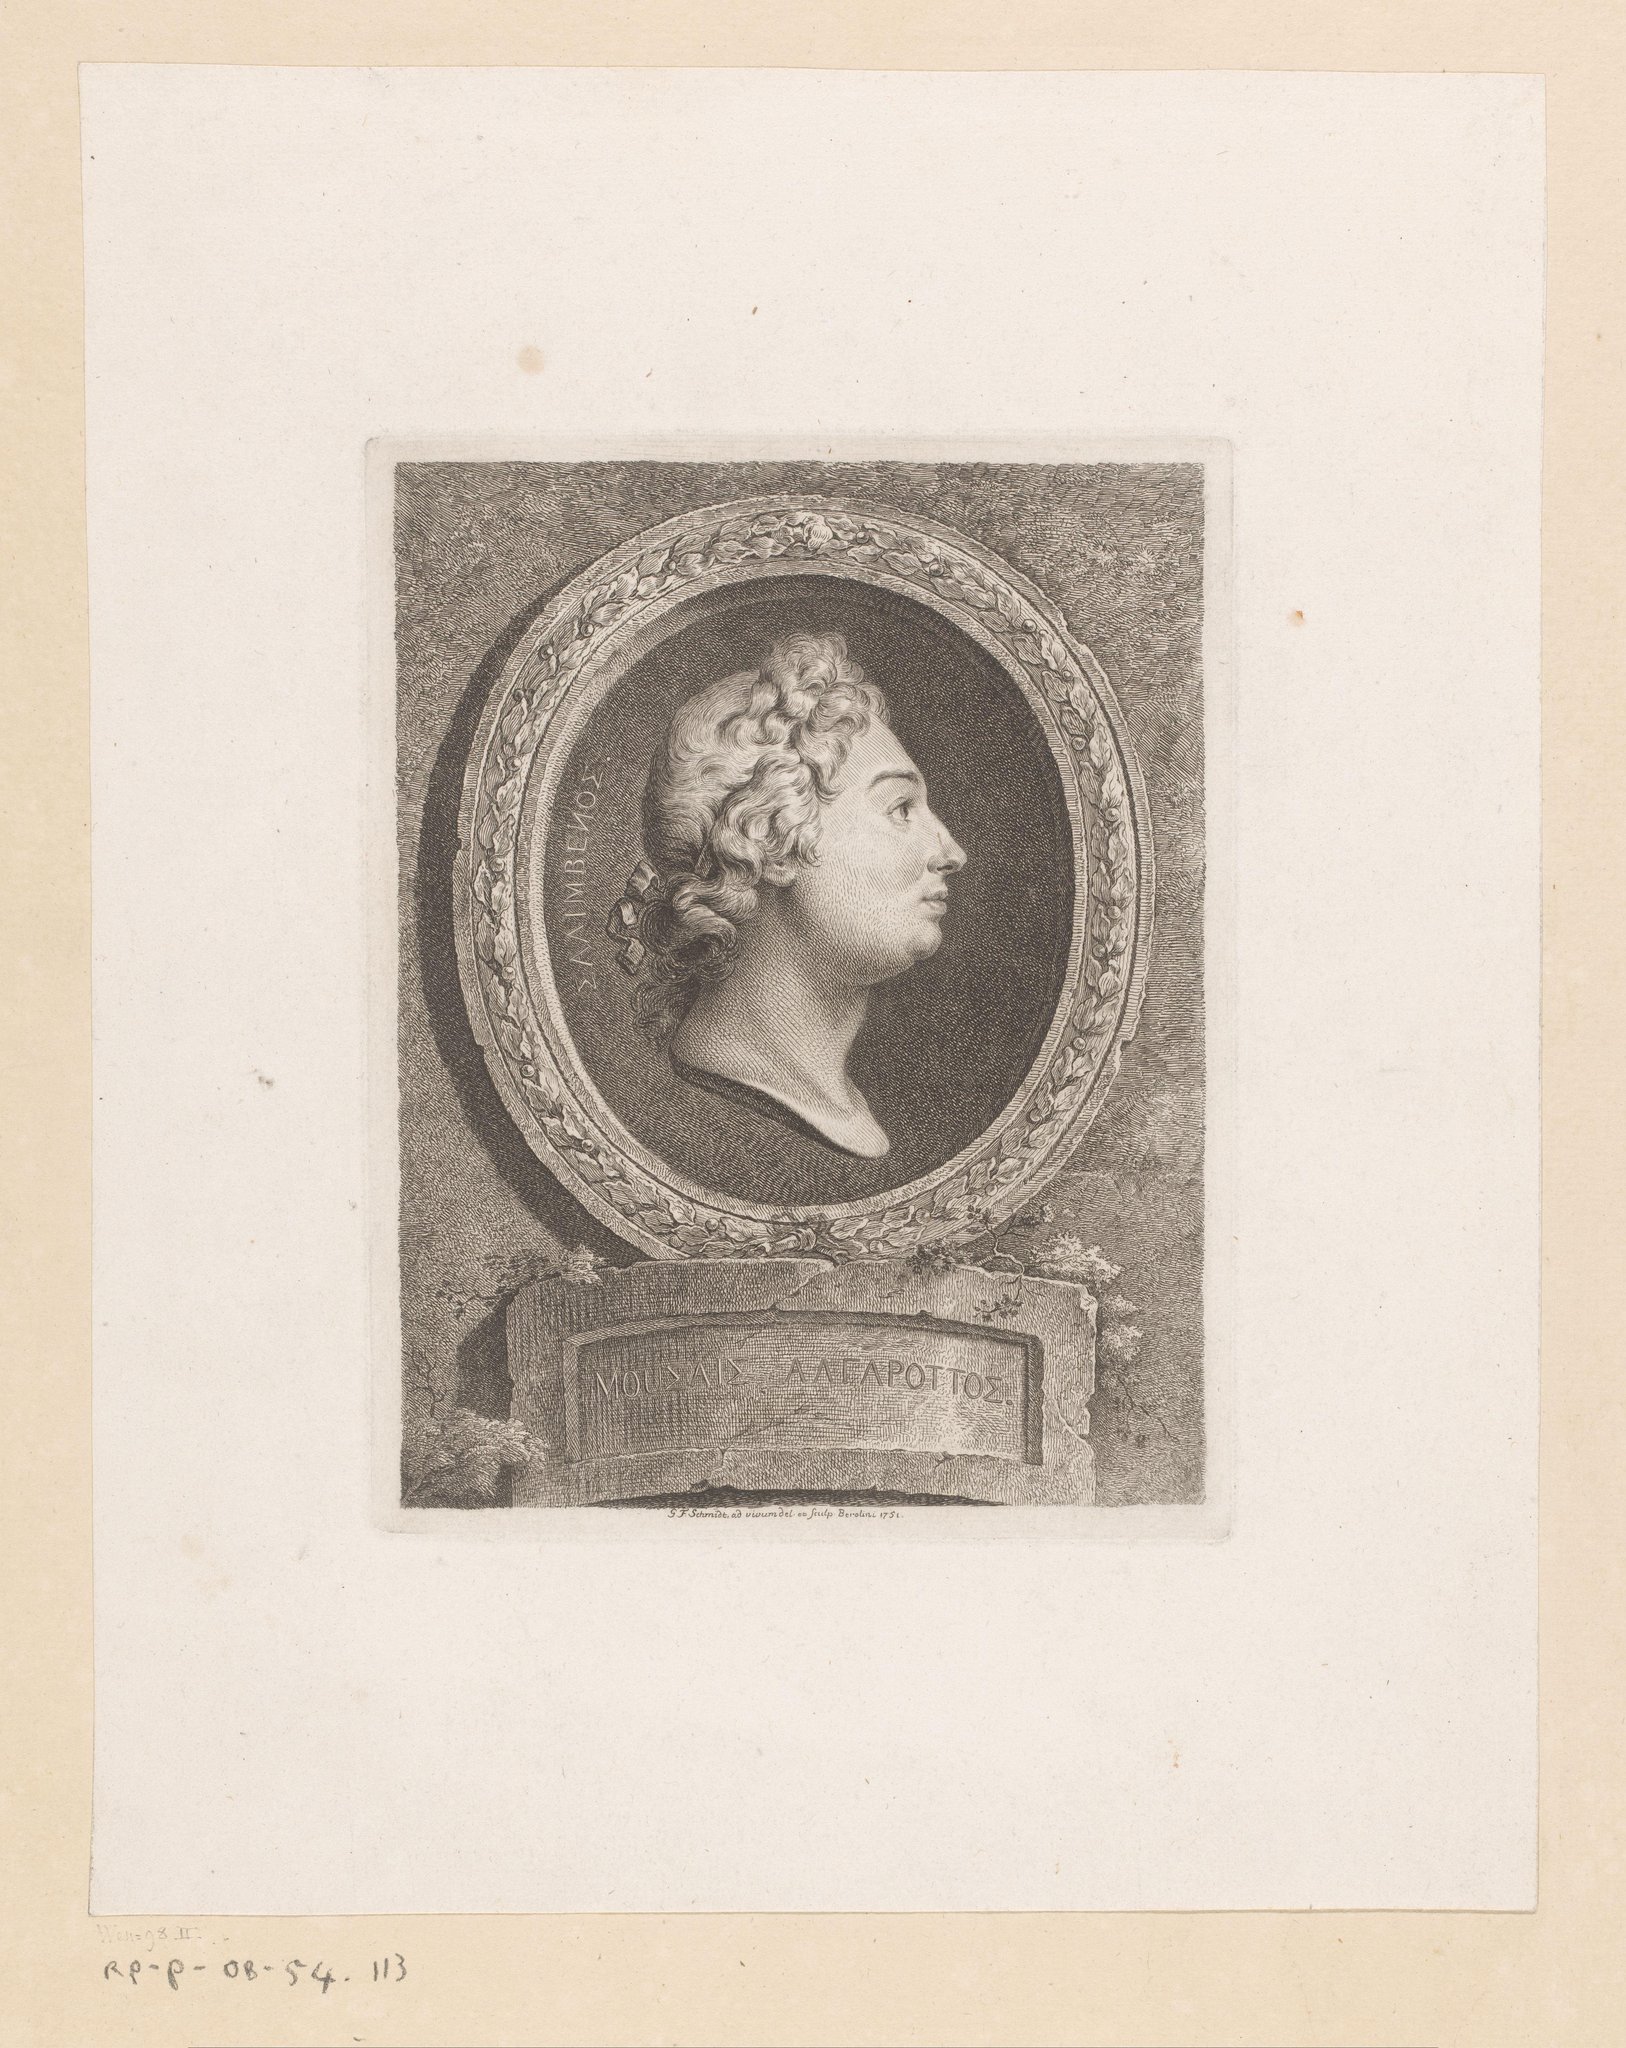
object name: print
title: Portret van Felice Salimbeni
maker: georg friedrich schmidt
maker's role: draughtsman, print maker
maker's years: 1712-1775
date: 1751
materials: paper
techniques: etching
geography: berlin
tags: historical persons - bb - woman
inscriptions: collector's mark: Lugt 240